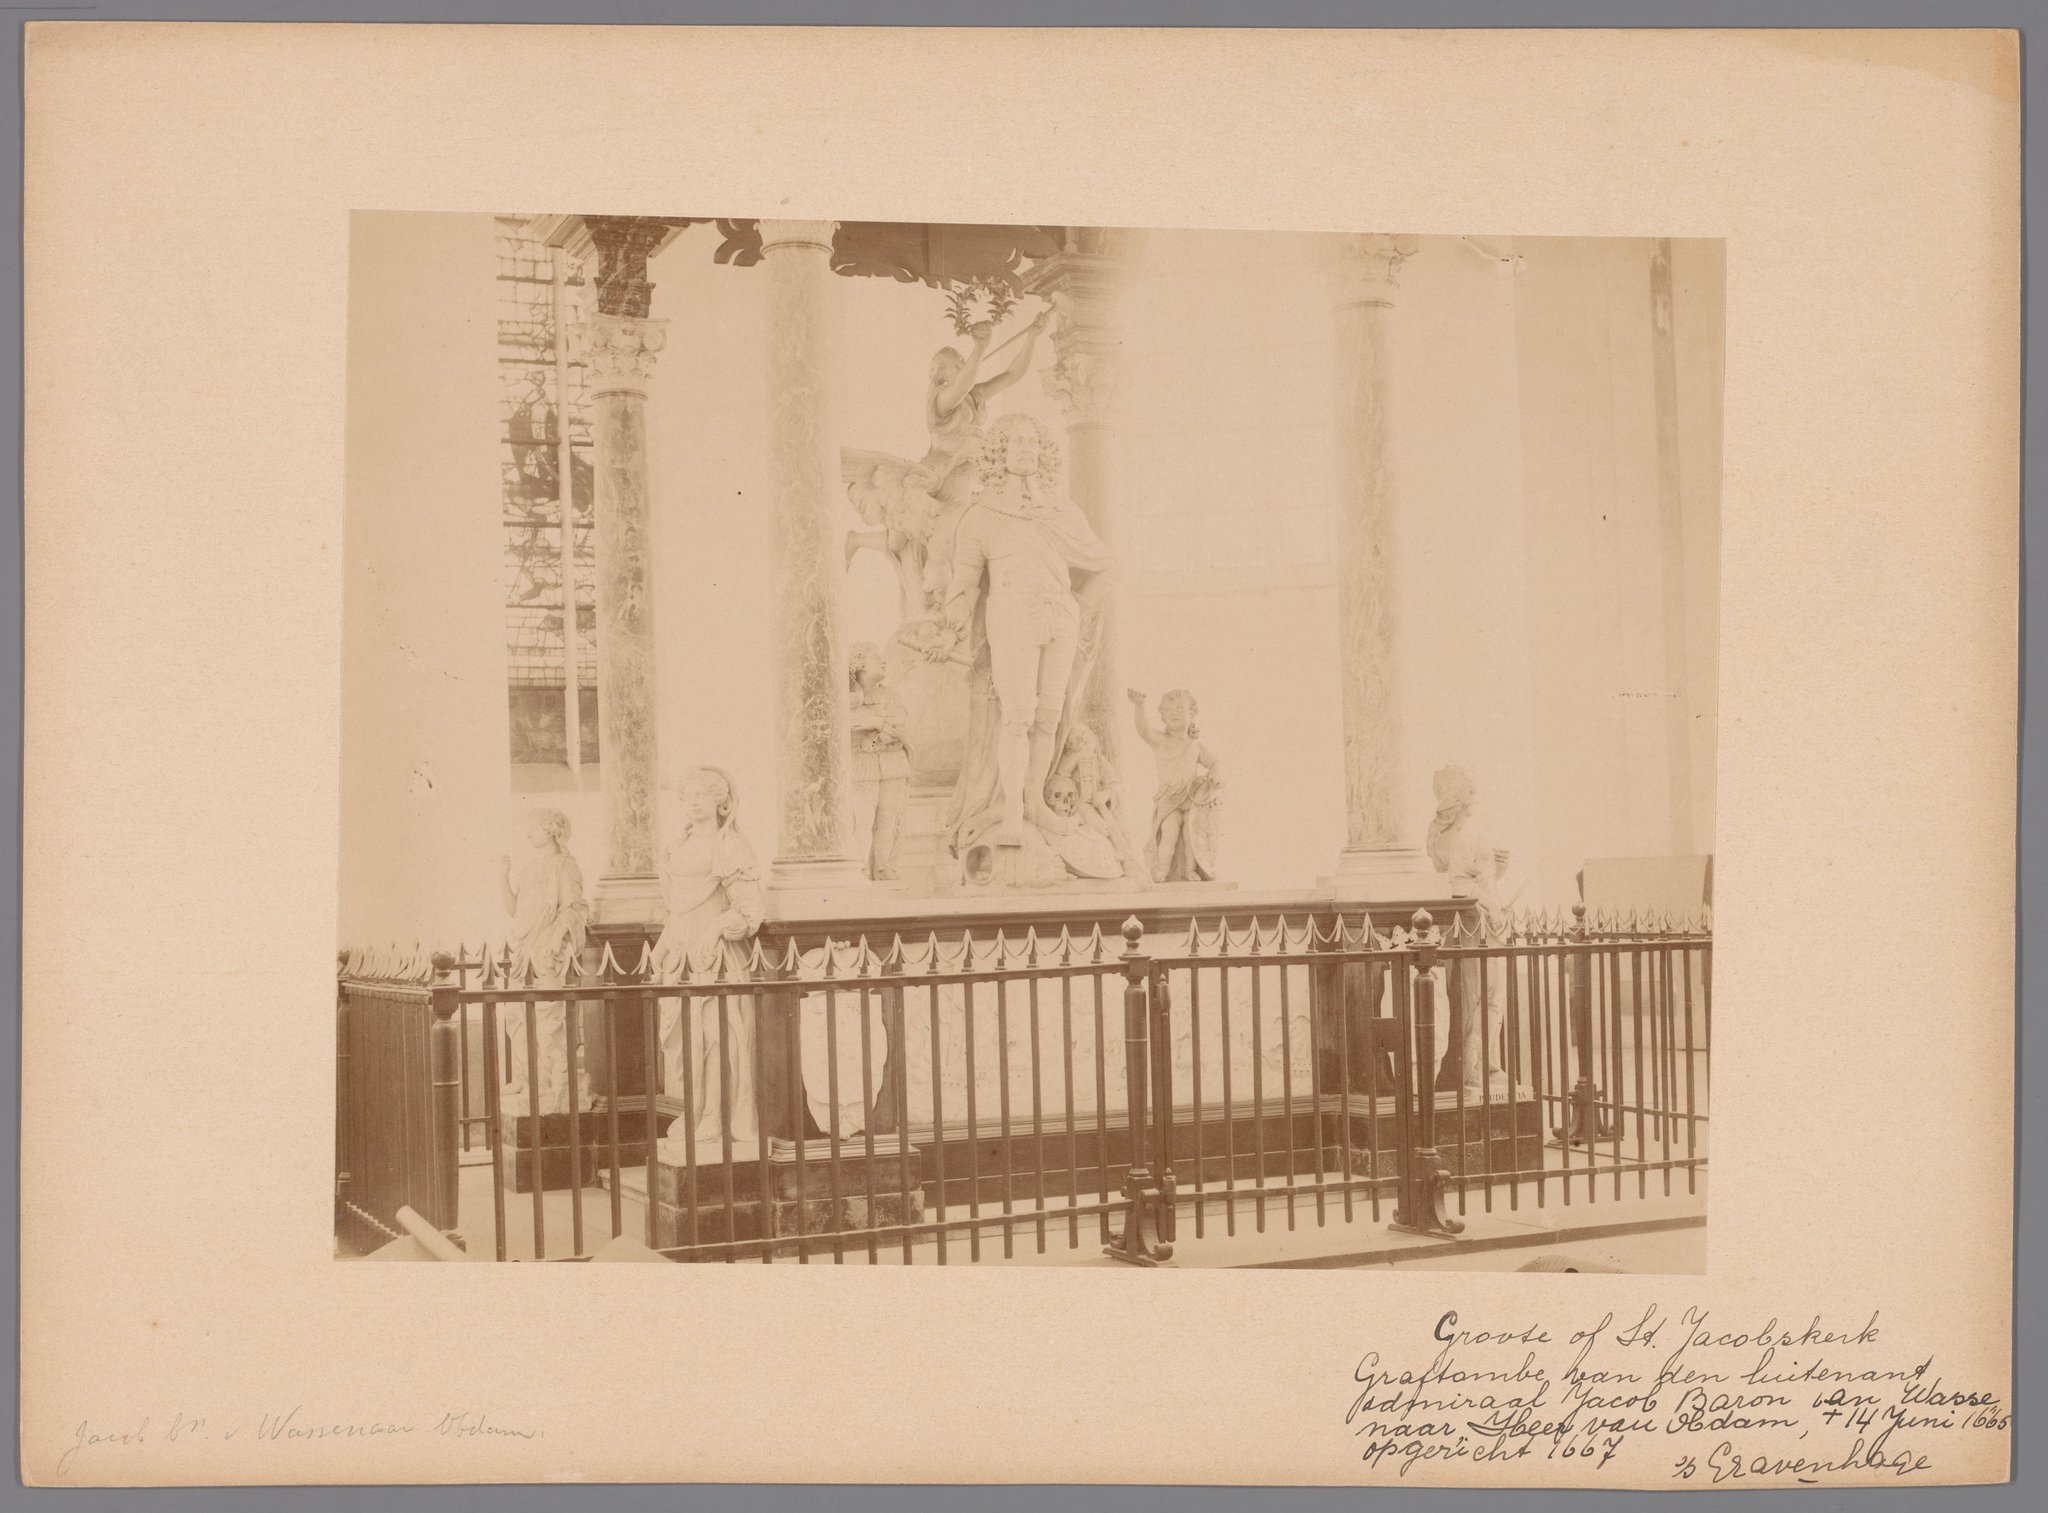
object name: photograph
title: Grafmonument van Jacob baron van Wassenaar heer van Obdam in de Grote of Sint-Jacobskerk te Den Haag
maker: anoniem (monumentenzorg)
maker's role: fotograaf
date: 1890-1920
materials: cardboard, photographic support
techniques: albumen print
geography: grote kerk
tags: jacob baron van wassenaer heer van obdam, interior of church, grave-building, monumental tomb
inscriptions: annotation: ‘Jacob br. v. Wassenaar Obdam/ Groote of St. Jacobskerk/ Graftombe van den buitenkant admiraal Jacob Baron van Wassenaar Heer van Obdam, 14 Juni 1665 opgericht 1667/ 's Gravenhage’, annotation: ‘Haag/ s. Jacobskerk/ Graftombe van den buitenkant admiraal Jacob Baron van Wassenaar Heer van Obdam/ 14 Juni 1665/ opgericht in 1667’, collector's mark: ‘R:MUS.’ Lugt 2228